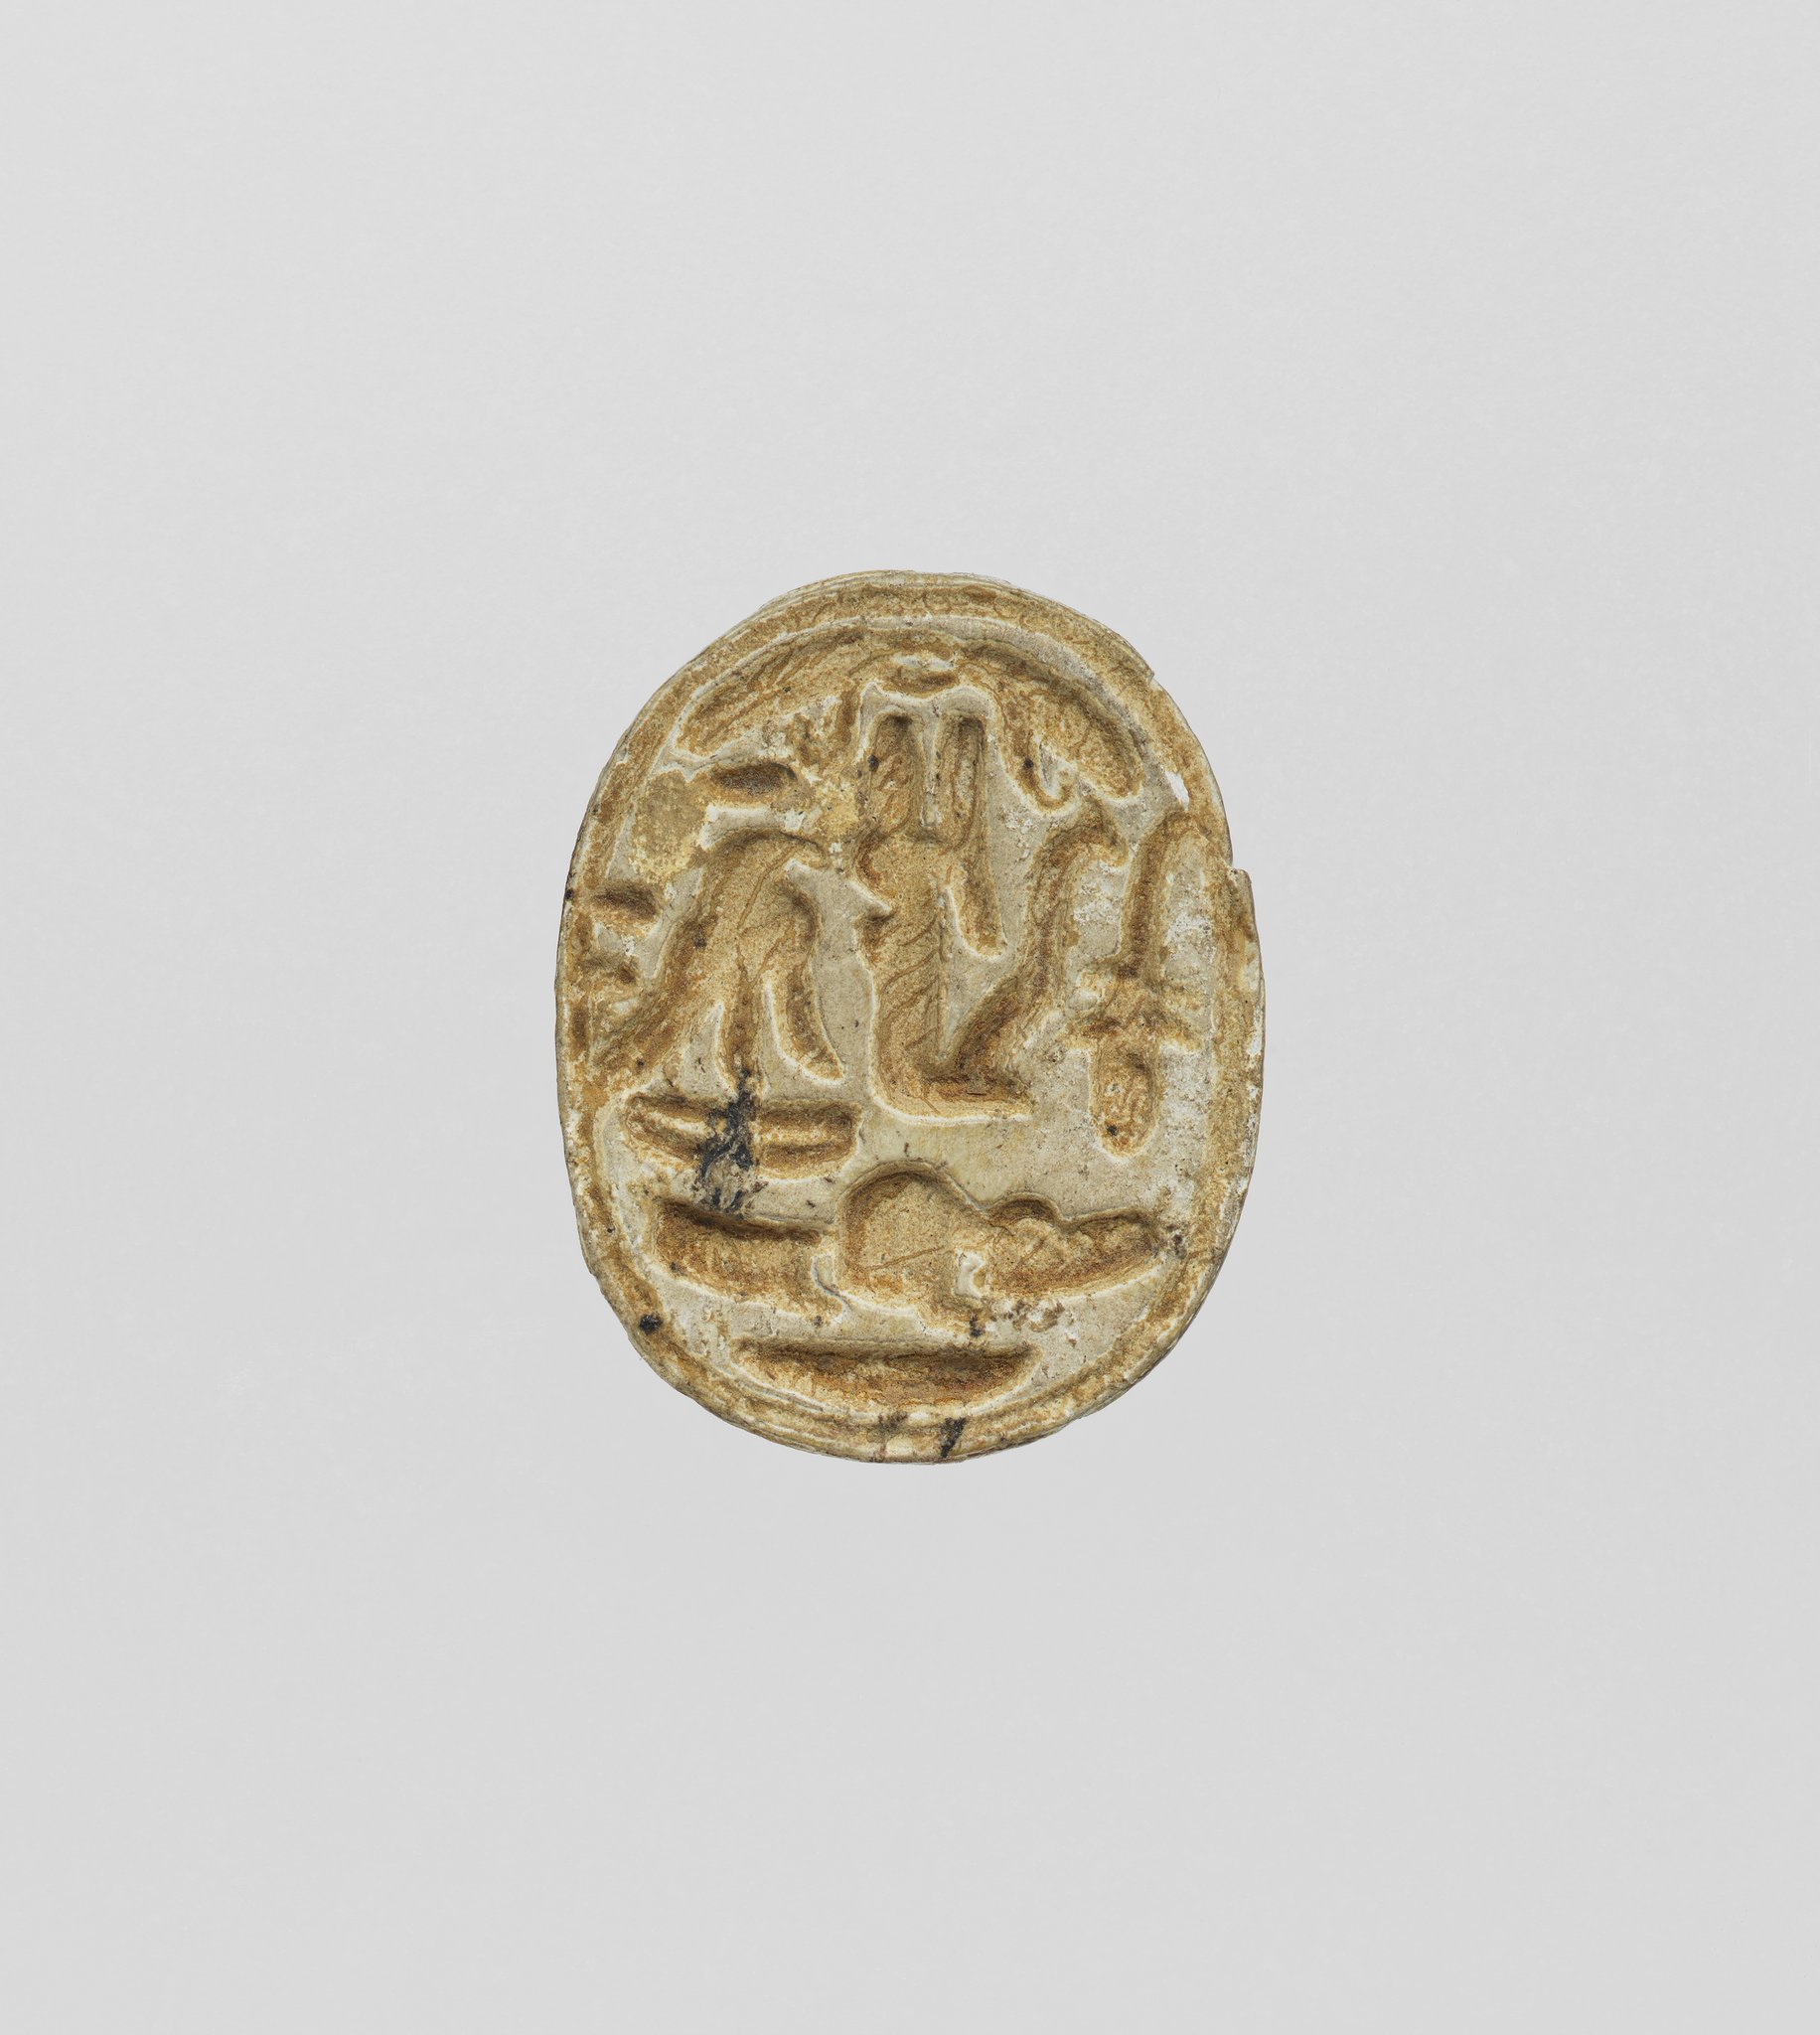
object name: scarab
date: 1295-1070 BCE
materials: faience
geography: egypt